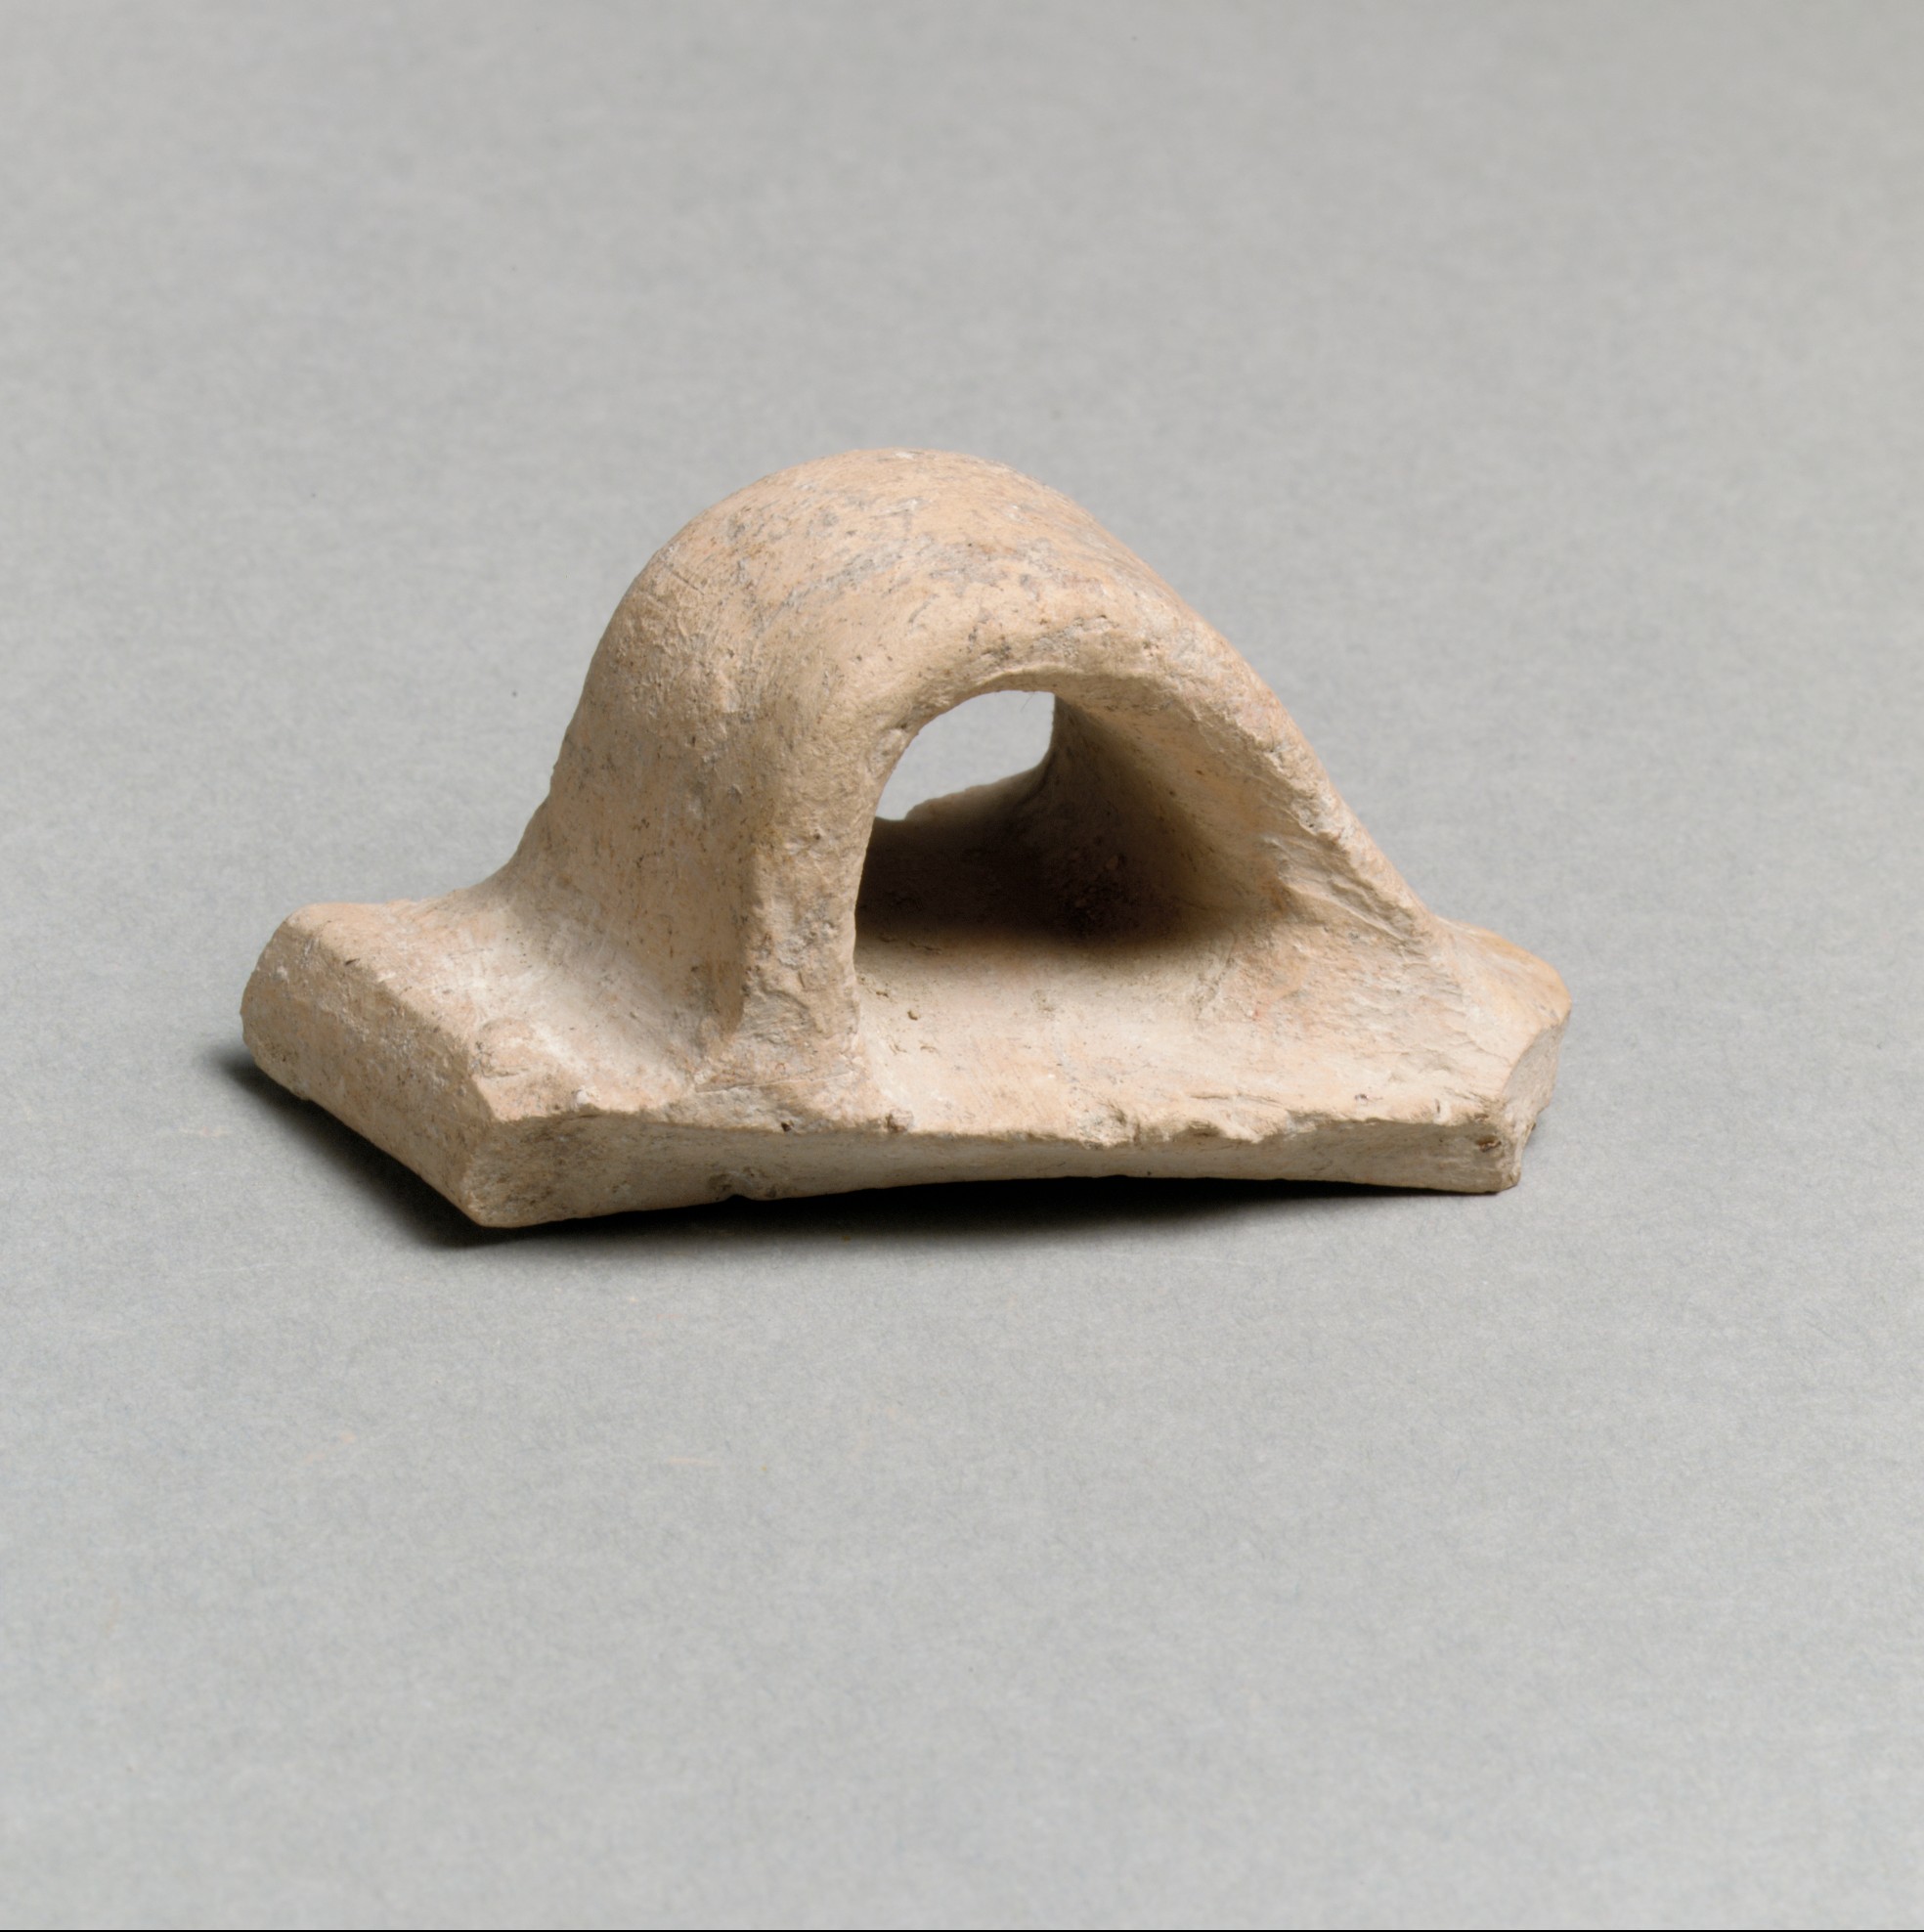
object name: vase fragment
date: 3000-2200 BCE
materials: terracotta